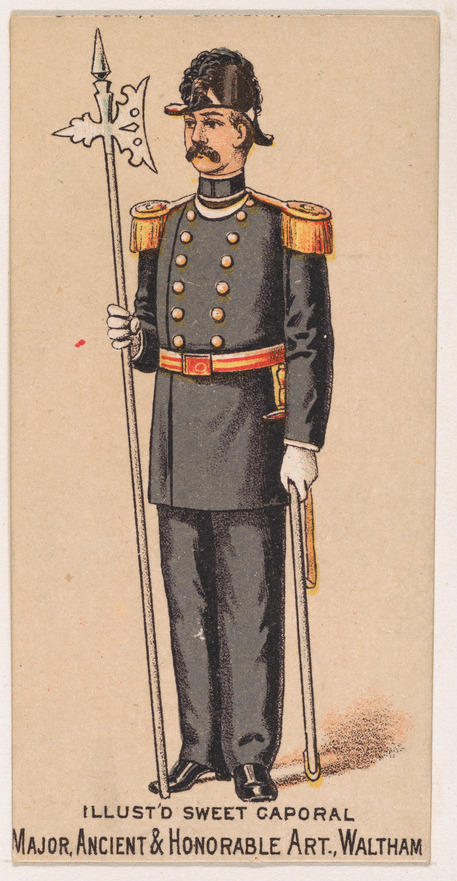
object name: print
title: Major, Ancient and Honorable Artillery, Waltham, Massachusetts, from the Military Series (N224) issued by Kinney Tobacco Company to promote Sweet Caporal Cigarettes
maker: kinney brothers tobacco company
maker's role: publisher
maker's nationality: american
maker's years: 1869-2011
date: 1888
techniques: color lithograph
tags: military,weapons,men